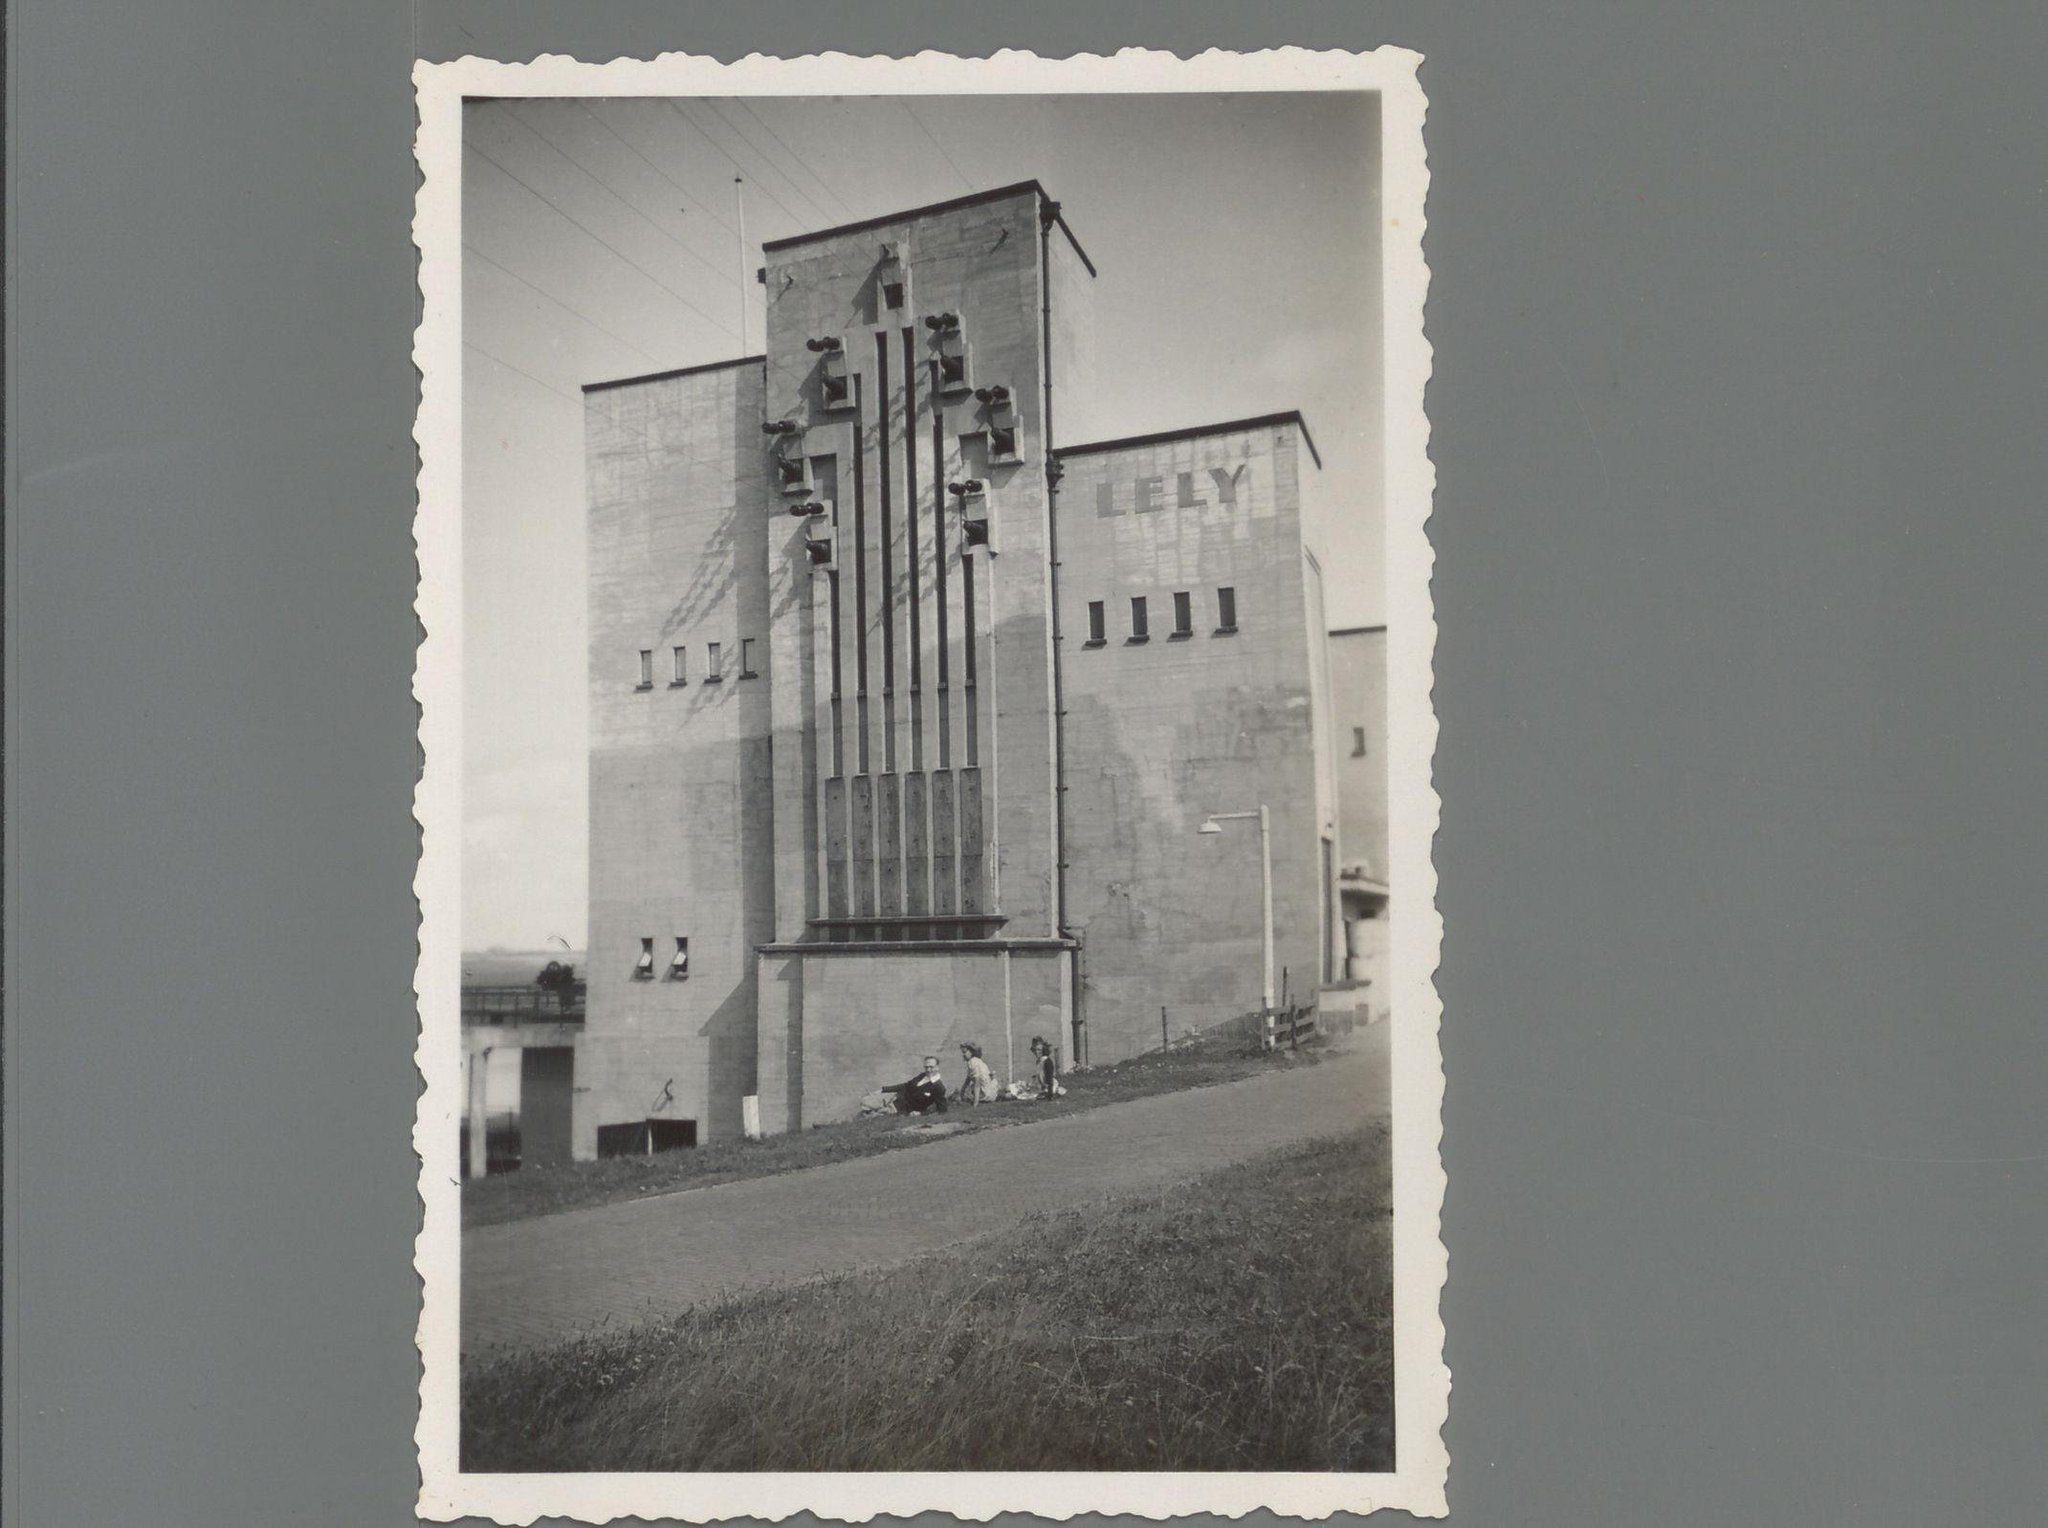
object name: photograph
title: Gezicht op Gemaal Lely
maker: Anonymous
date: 1943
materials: paper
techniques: gelatin silver print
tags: sluice, weir, façade (of house or building)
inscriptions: factory mark: ‘Ridax’, inscription: ‘Elec. watergemaal Lely 1943’, number: ‘73’